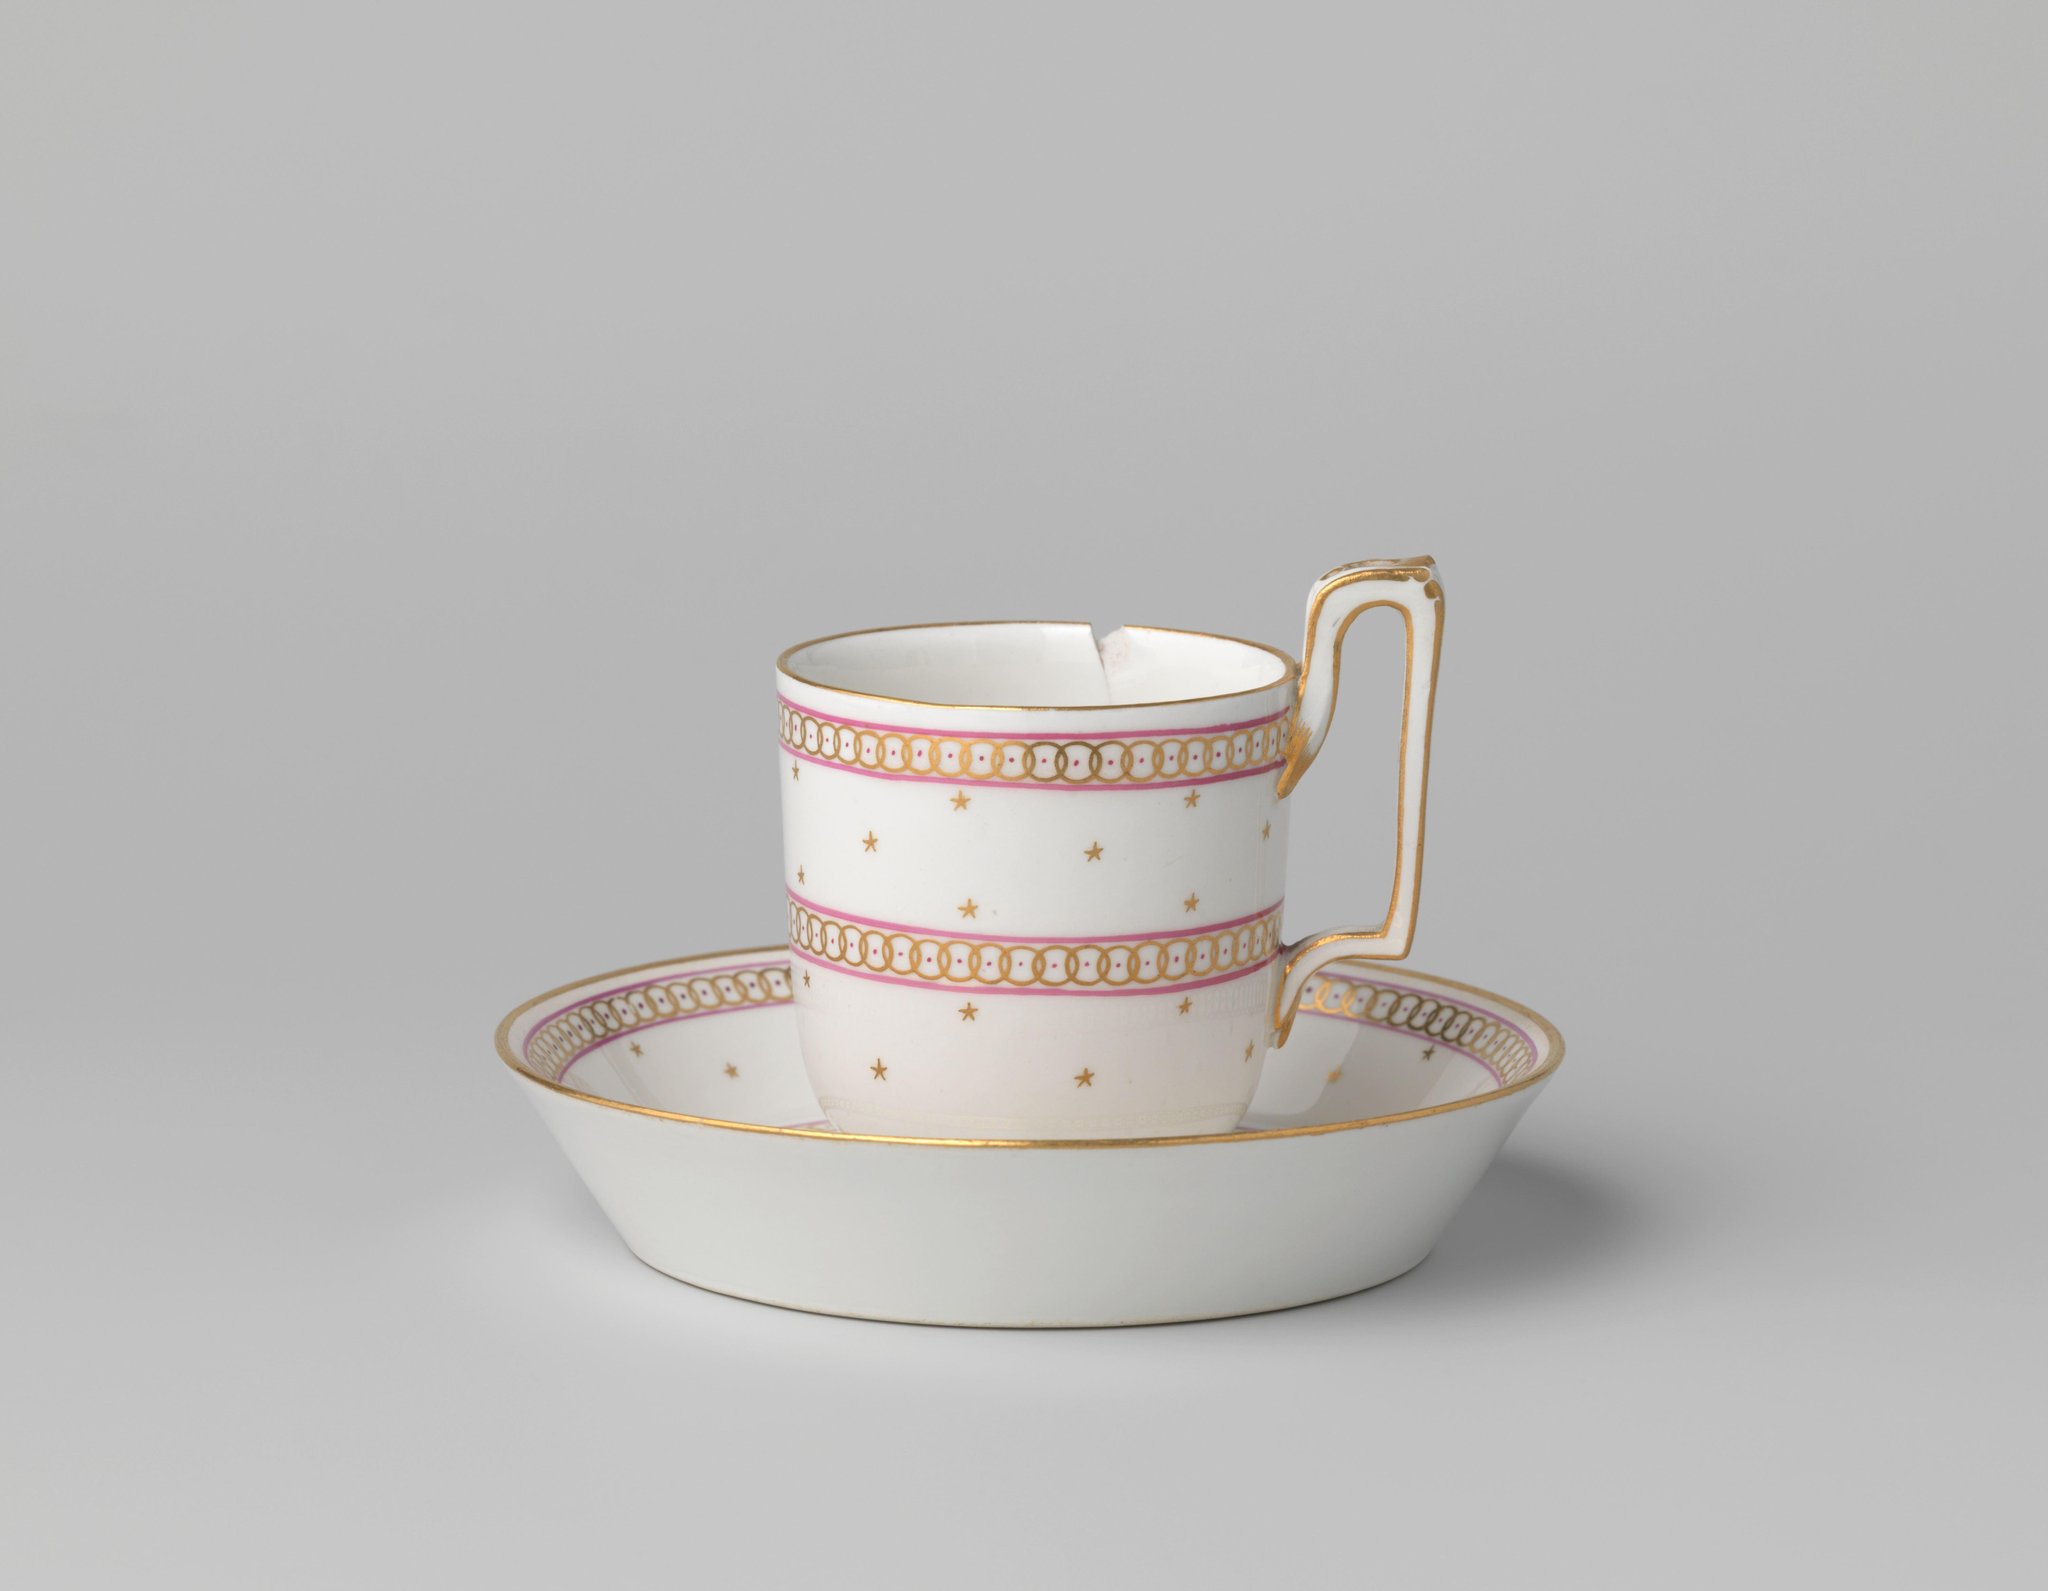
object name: kop en schotel, kop en schotel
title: Cup and saucer with stars and ornamental borders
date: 1791-1801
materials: glaze, gold, paint, porcelain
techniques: firing, forming, gilding, turning, vitrification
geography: vienna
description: Cup and saucer. Porcelain. Vienna, 1791. Given by Mrs J.E.F.E. de Kleyn-von Artner, 1956.